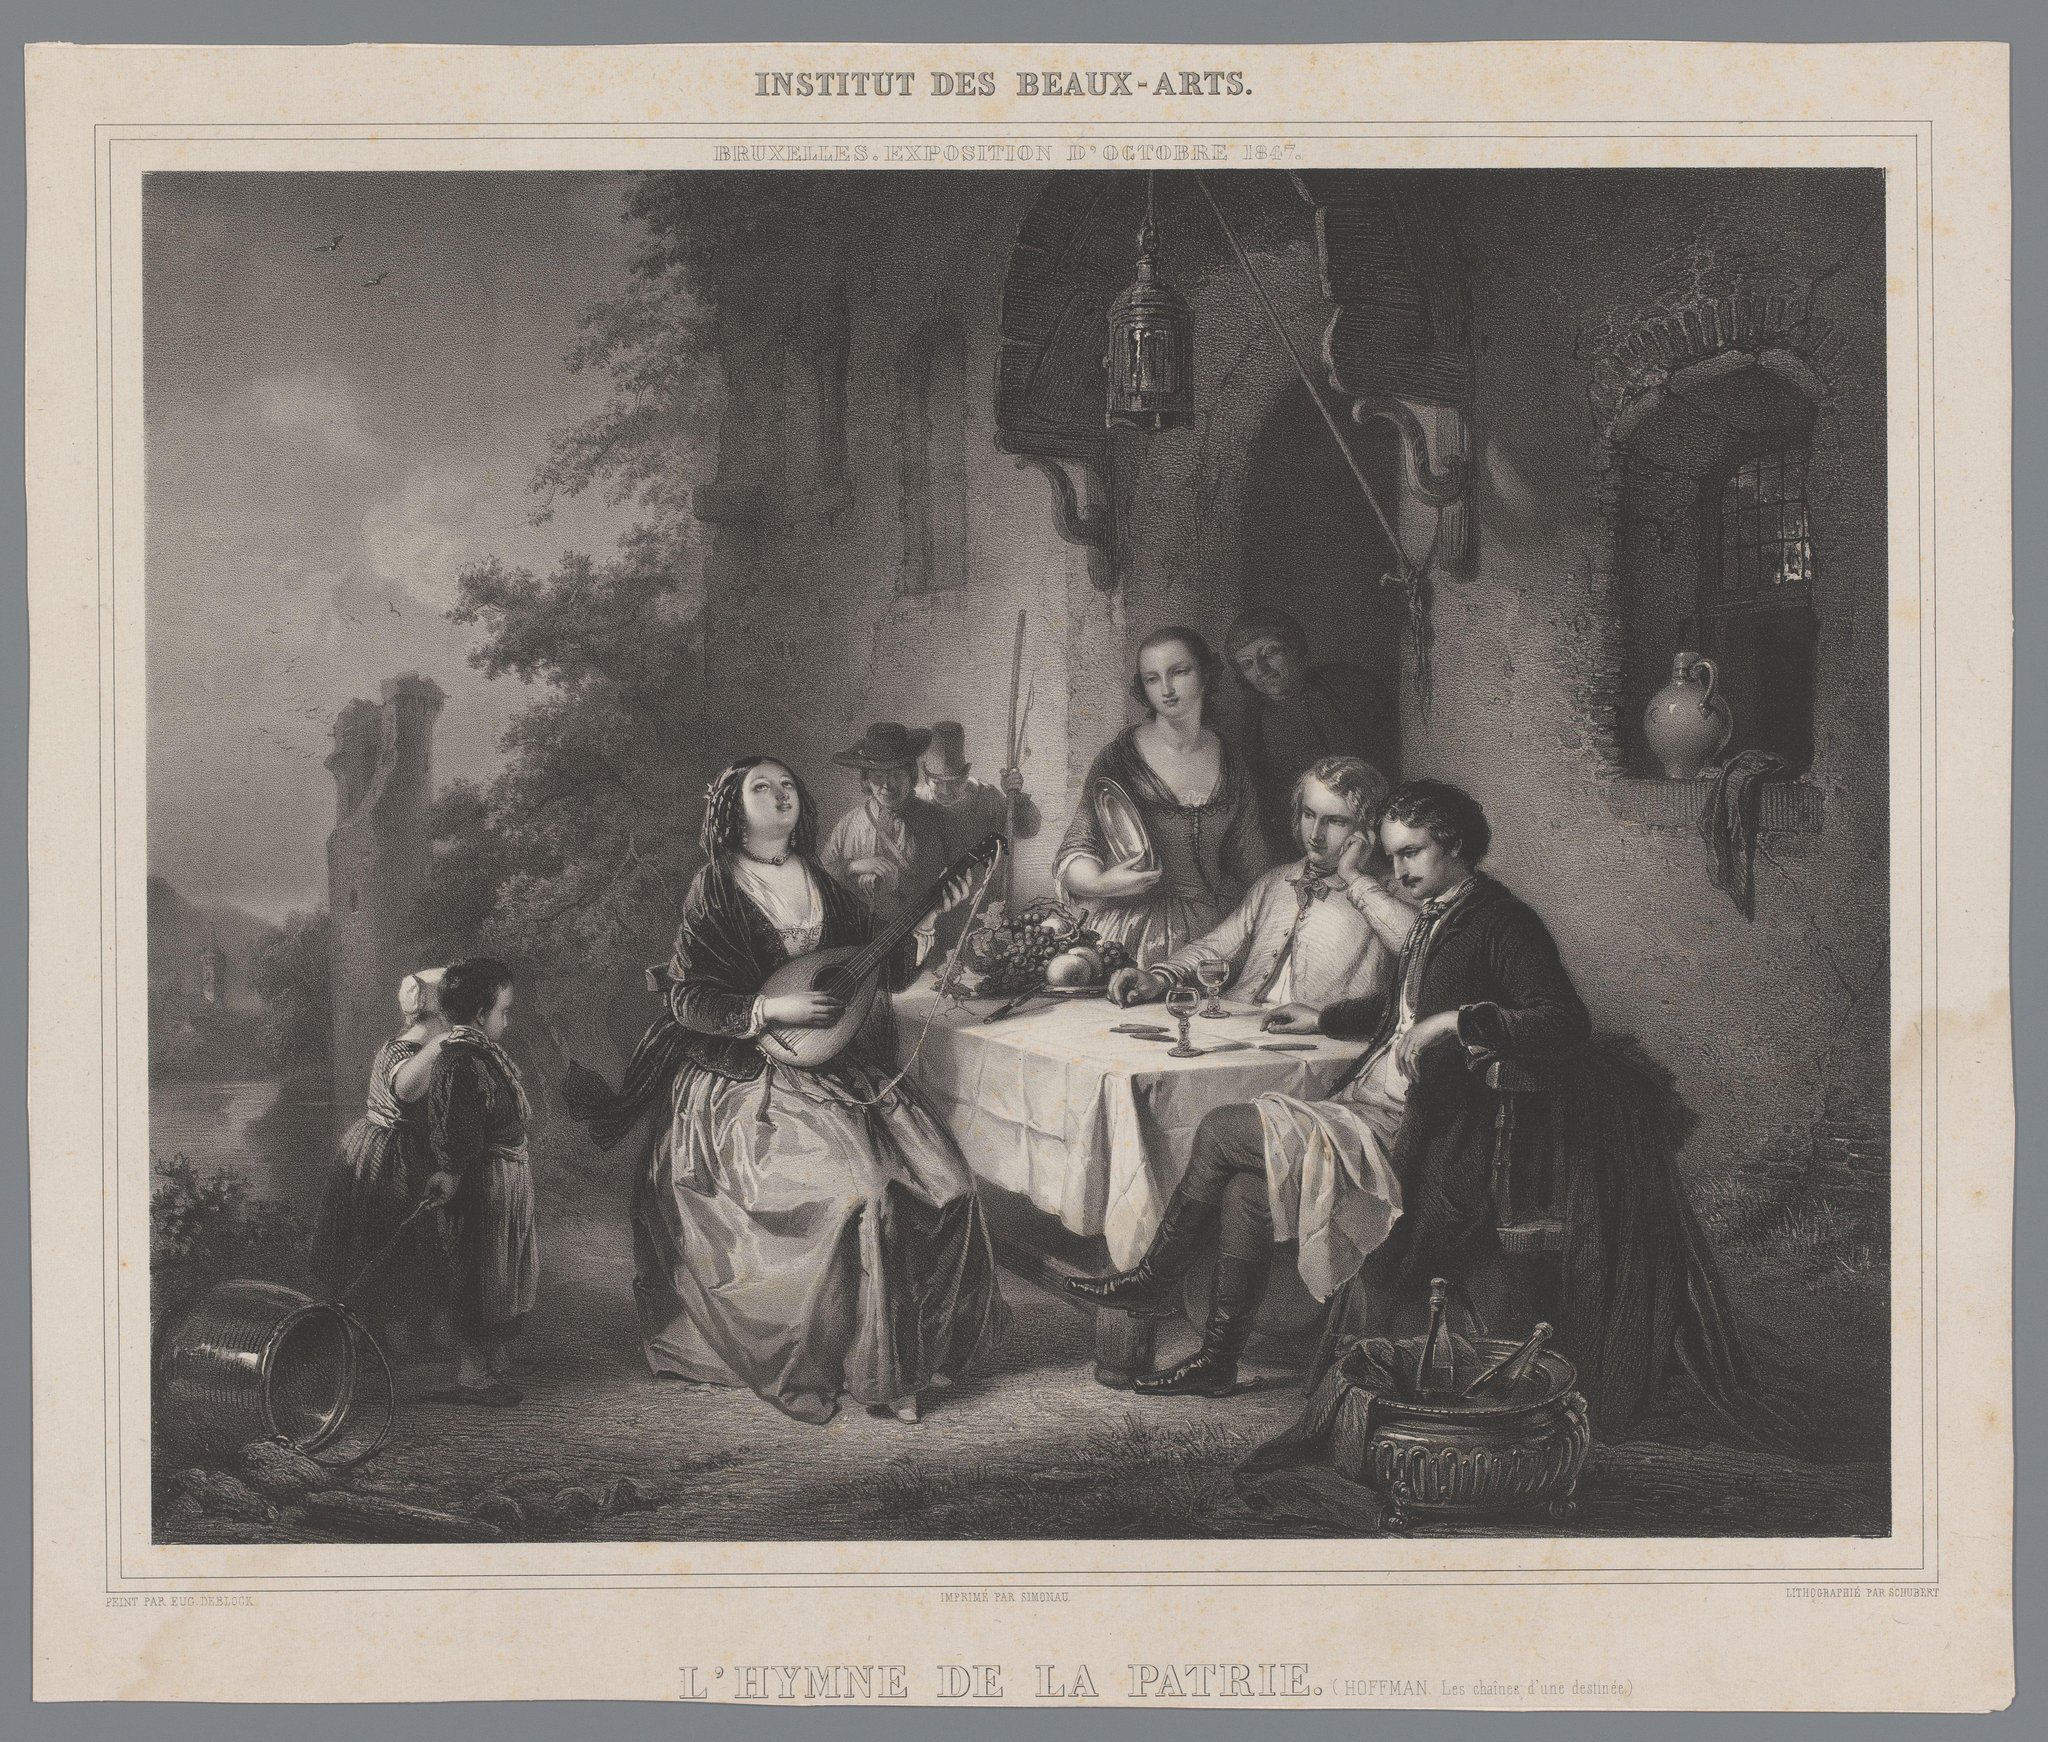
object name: print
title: Gezelschap met musicerende vrouw aan tafel voor een herberg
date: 1847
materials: paper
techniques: lithograph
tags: cithern, mandolin, guitar, balalaika - cc - out of doors, pavement, terrace in front of inn or restaurant, private festivities, merry company - aa - in the open air, 'fête champêtre'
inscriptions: collector's mark: Lugt 2228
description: Prent behoort mogelijk tot een serie prenten met tentoongestelde kunstwerken van het Institut des Beaux-Arts.